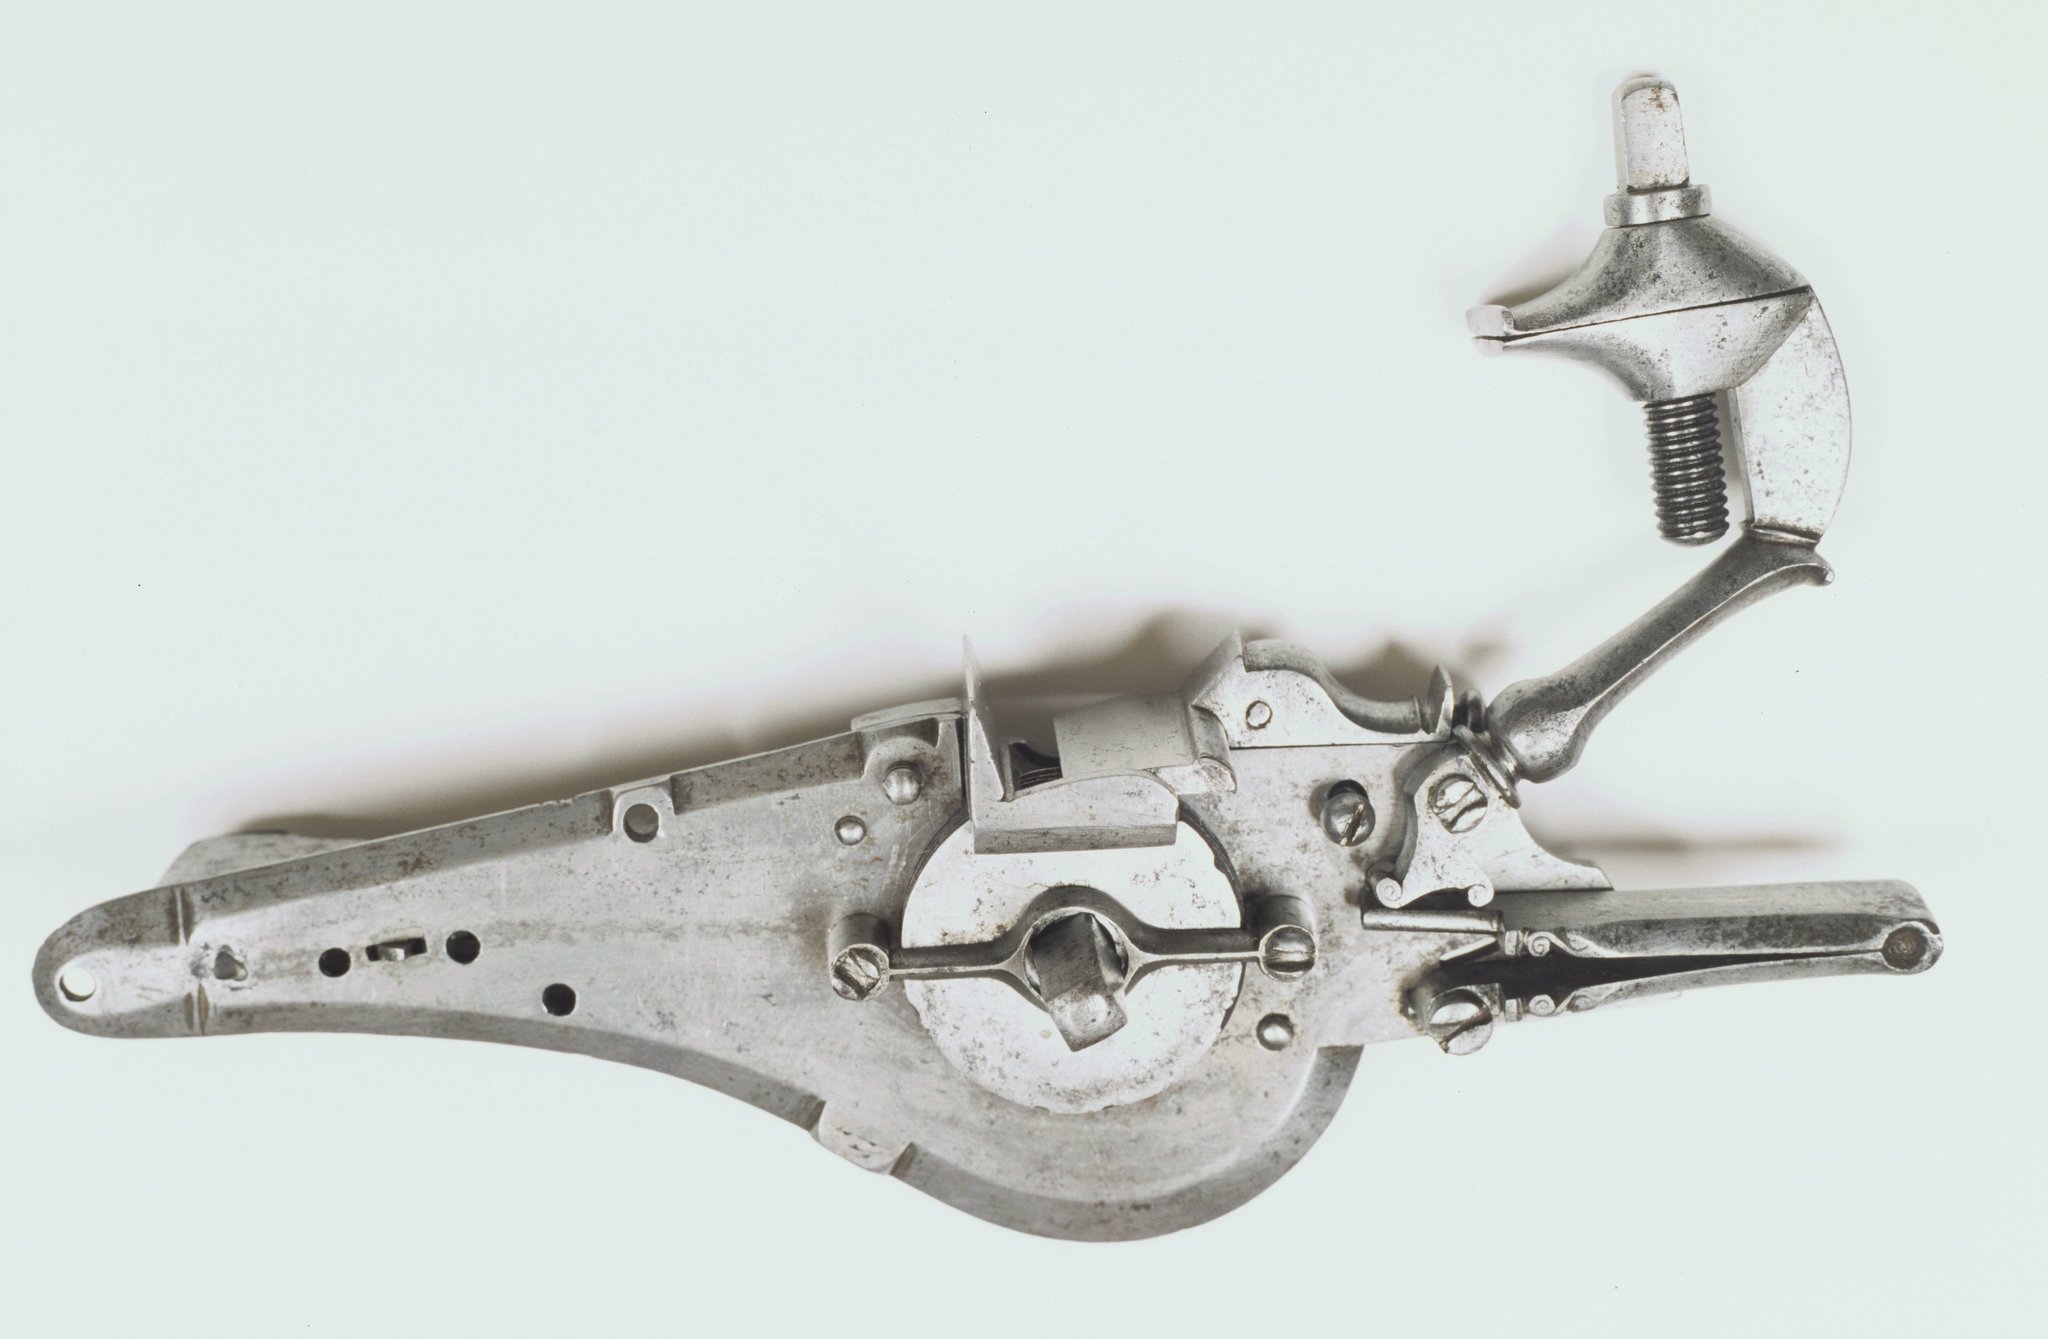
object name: radslot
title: Radslot van een geweer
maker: Anonymous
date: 1600-1650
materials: iron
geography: france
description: Radslot met buitenliggend rad. Een smalle band, welke ringvormig om de vierkantige, uitstekende as sluit, houdt d.m.v. een bout aan de voor- en achterzijde van het rad, deze op de slotplaat vast. Vlakke slotplaat, schuivend pandeksel. Tussen de bout van de haan en de bout van de haanveer heeft zich waarschijnlijk een verbindingsstrook bevonden. Op het achterste gedeelte van de slotplaat, heeft zich een, thans ontbrekend, mechanisme bevonden, dat diende als veiligheidsmechanisme voor de trekker.